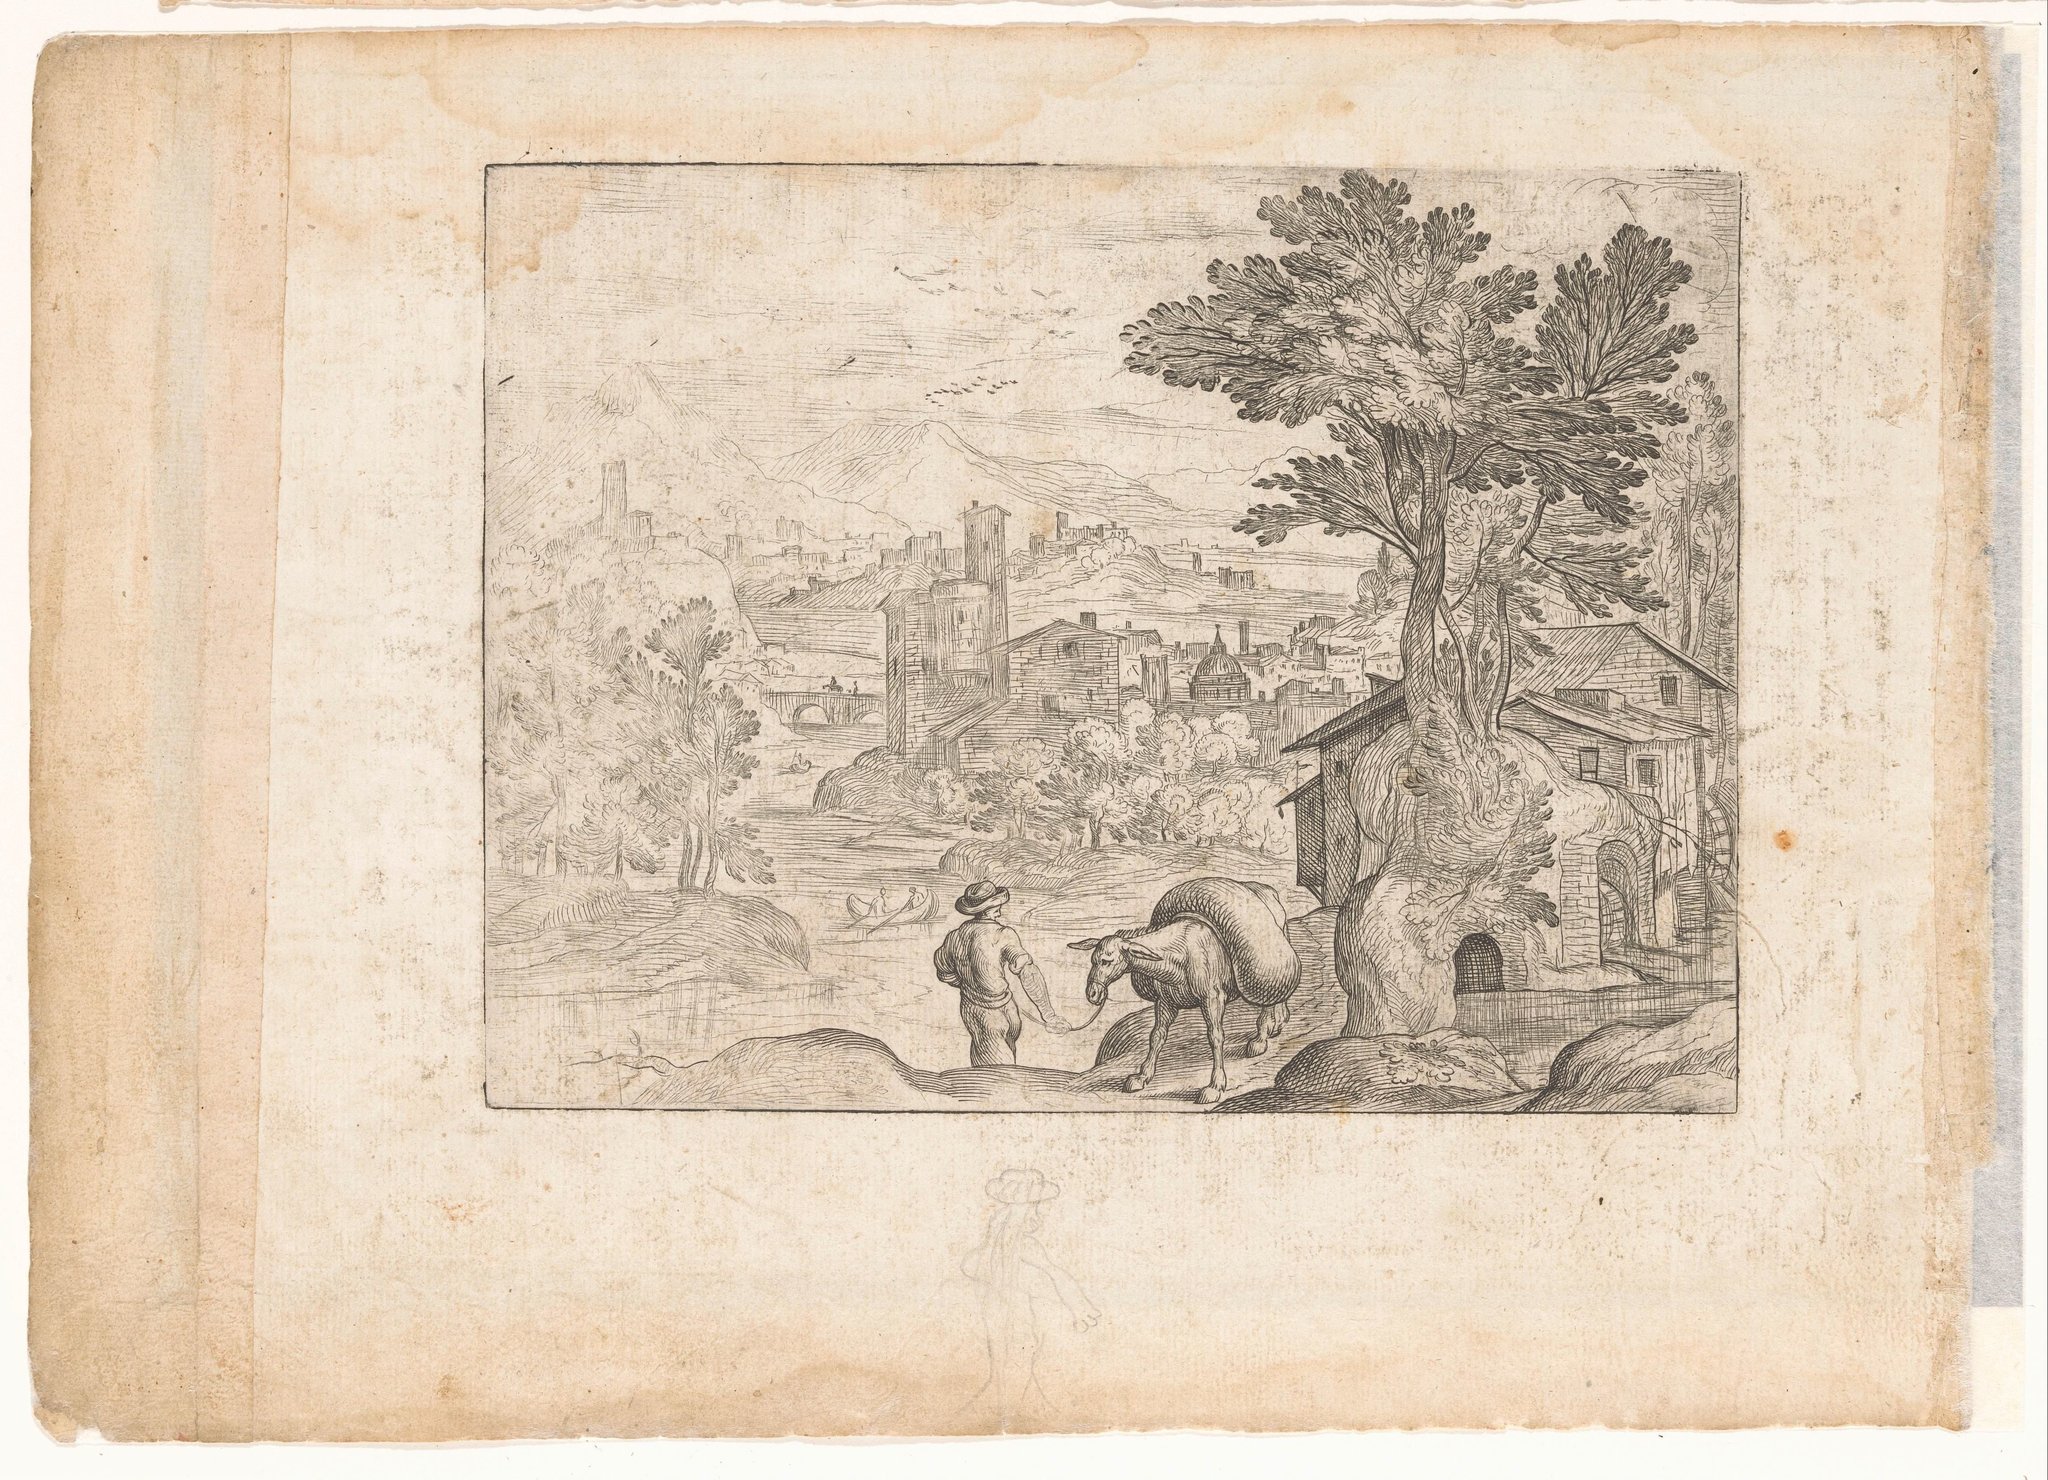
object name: print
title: Landschap met man en ezel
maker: antonio tempesta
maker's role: draughtsman, painter, print maker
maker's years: 1555-1630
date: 1565-1630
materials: paper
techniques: engraving, etching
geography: italy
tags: ass, donkey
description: Op de voorgrond daalt een man met geladen ezel een heuvelrug af in de richting van een stad met koepelkerk. Rechts op de voorgrond bevindt zich een huis met watermolen en een boom die het voorplan domineert. Door het rustieke landschap stroomt een rivier, waarop een bootje drijft met twee mensen erin. Op de achtergrond is een gebergte zichtbaar.